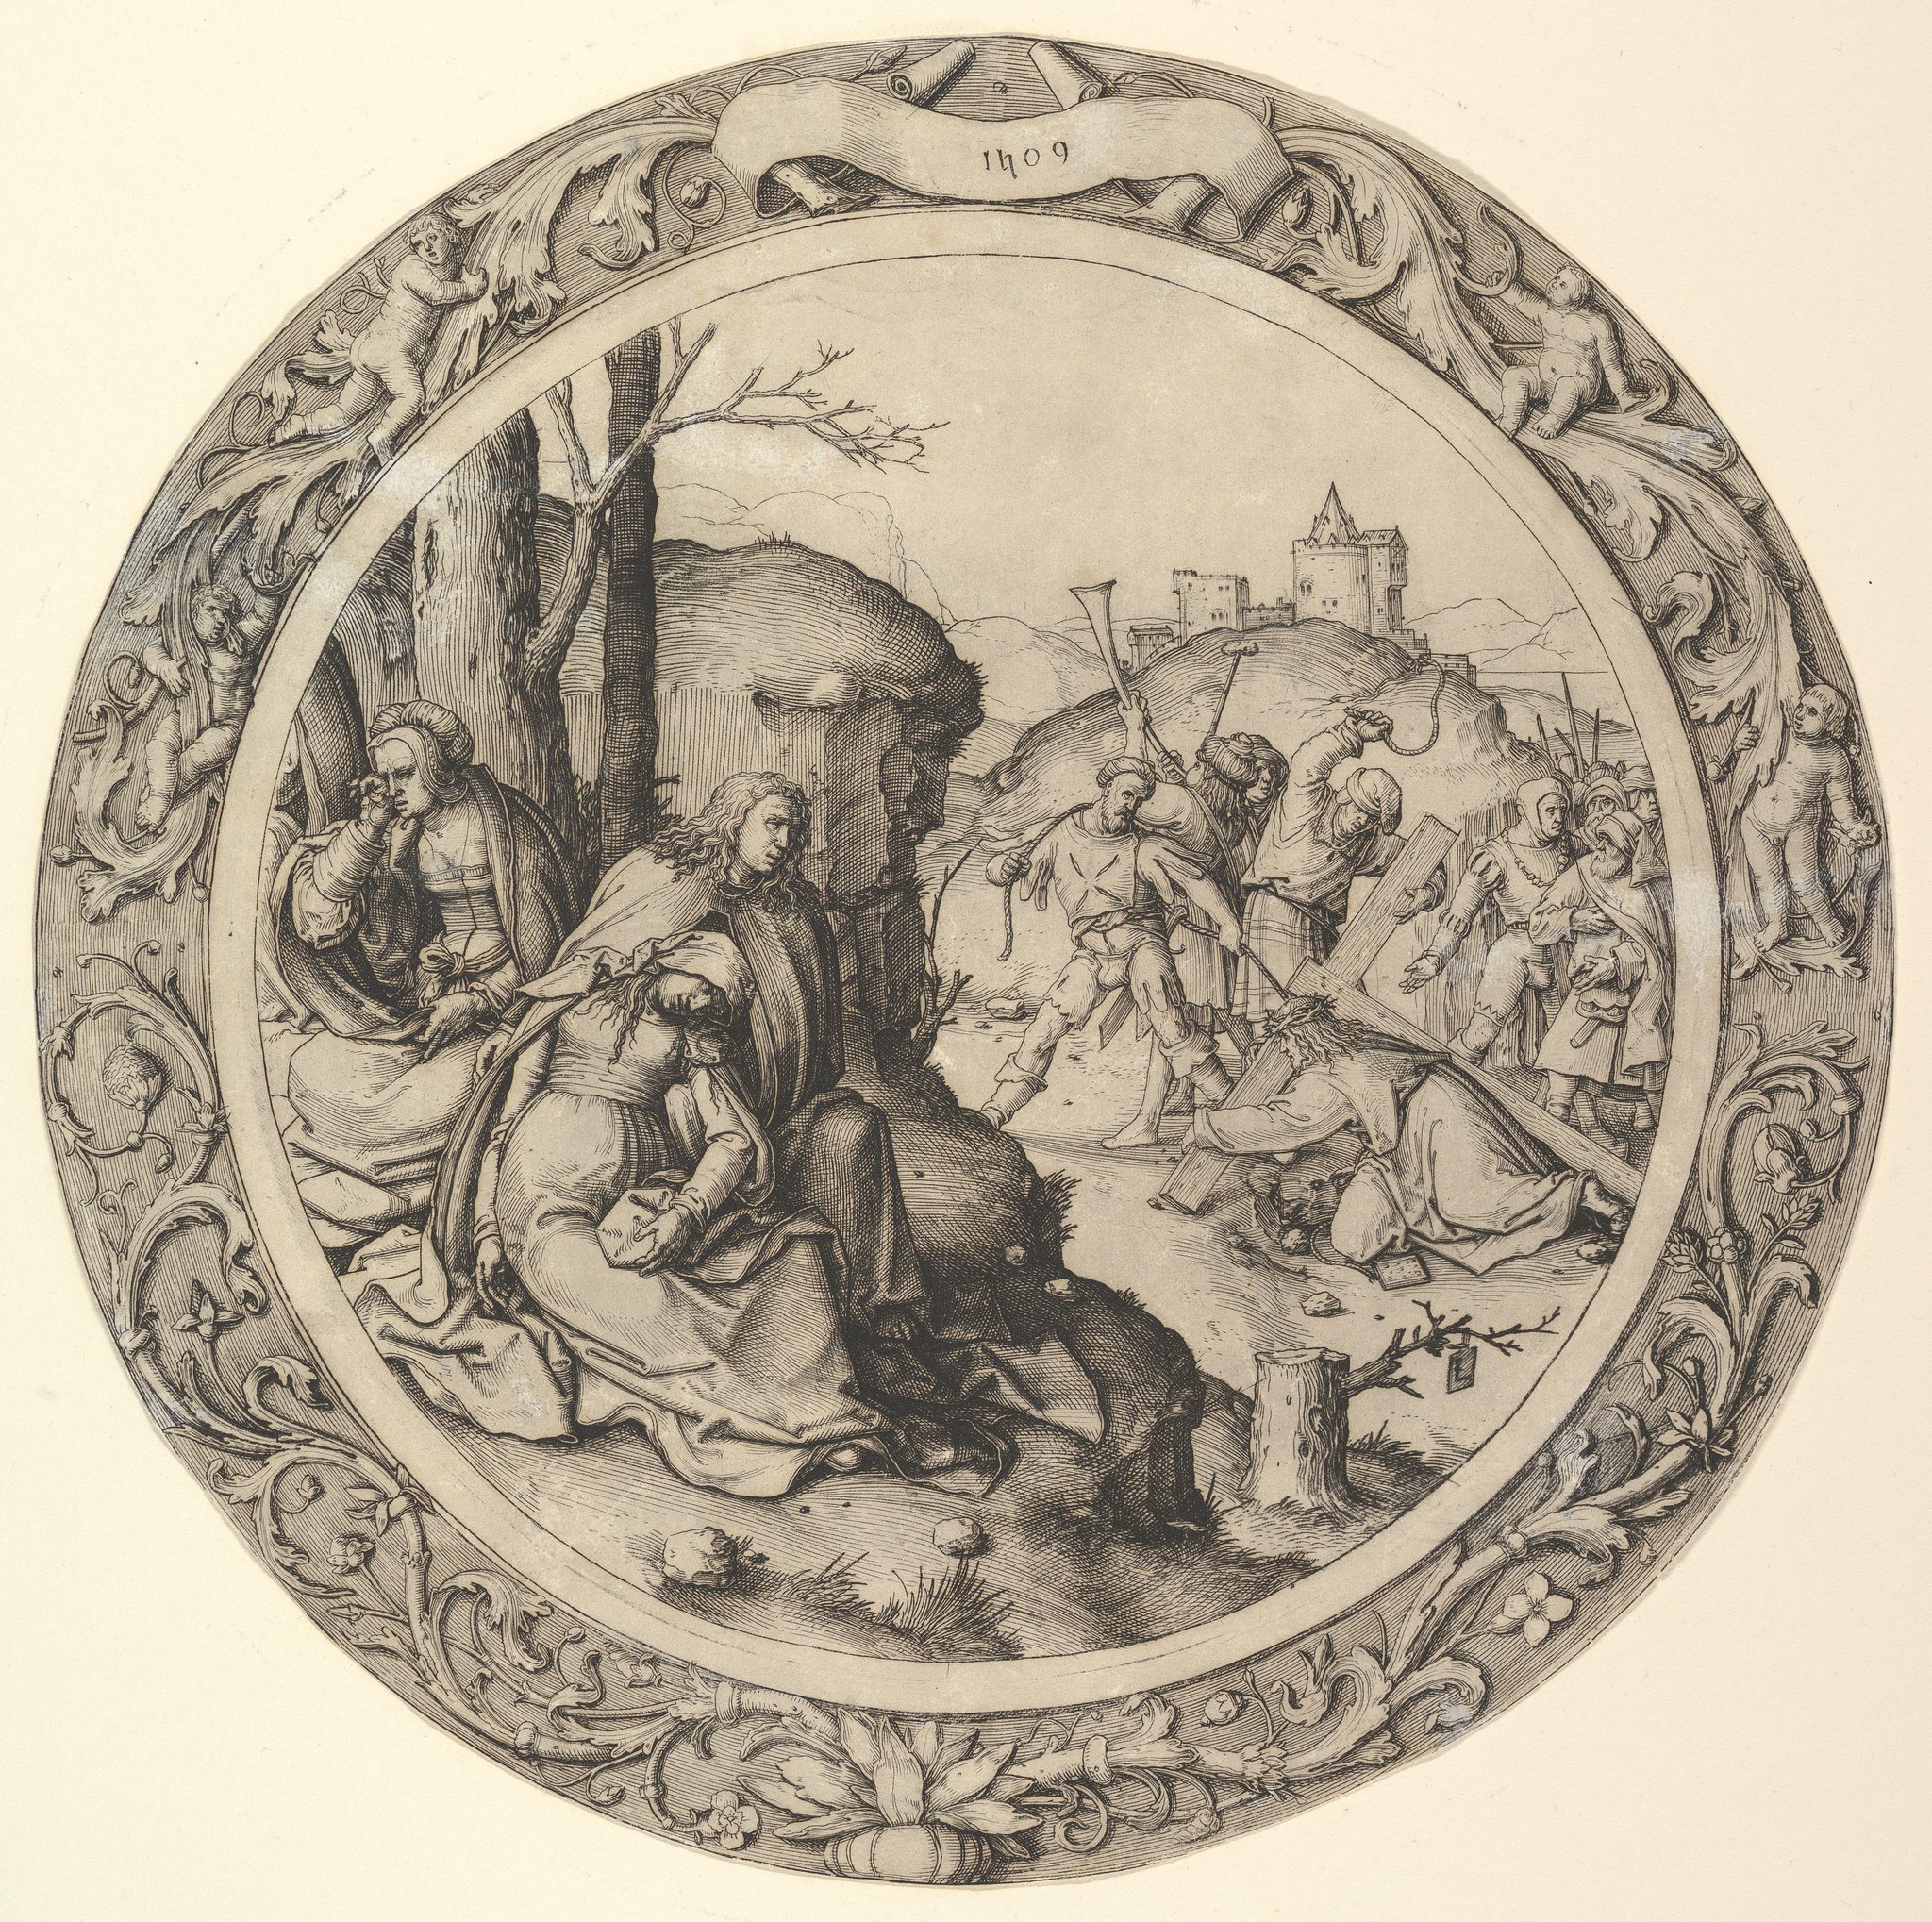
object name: print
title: Christ Carrying the Cross, from the Circular Passion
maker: lucas van leyden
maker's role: artist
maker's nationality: netherlandish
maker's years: 1494-1533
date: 1509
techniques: engraving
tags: men,women,christ,cross